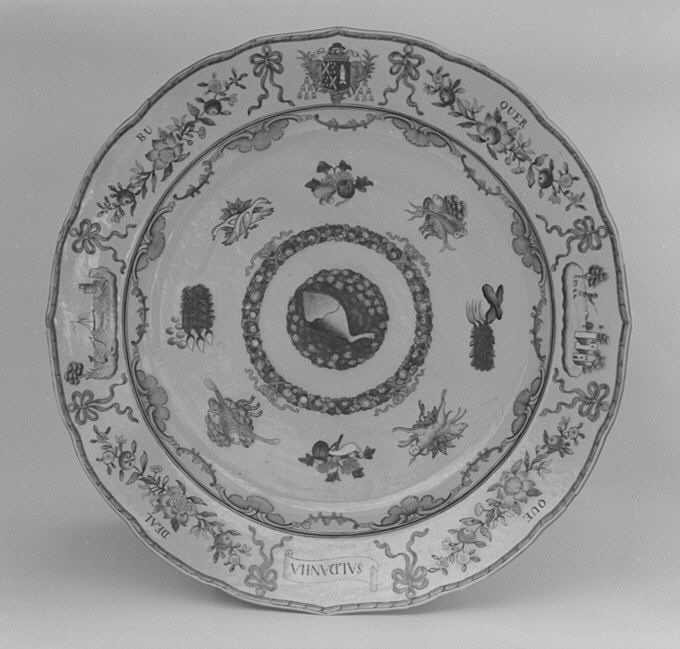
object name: plate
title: Plate (part of a service)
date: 1765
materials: hard paste porcelain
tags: flowers,coat of arms